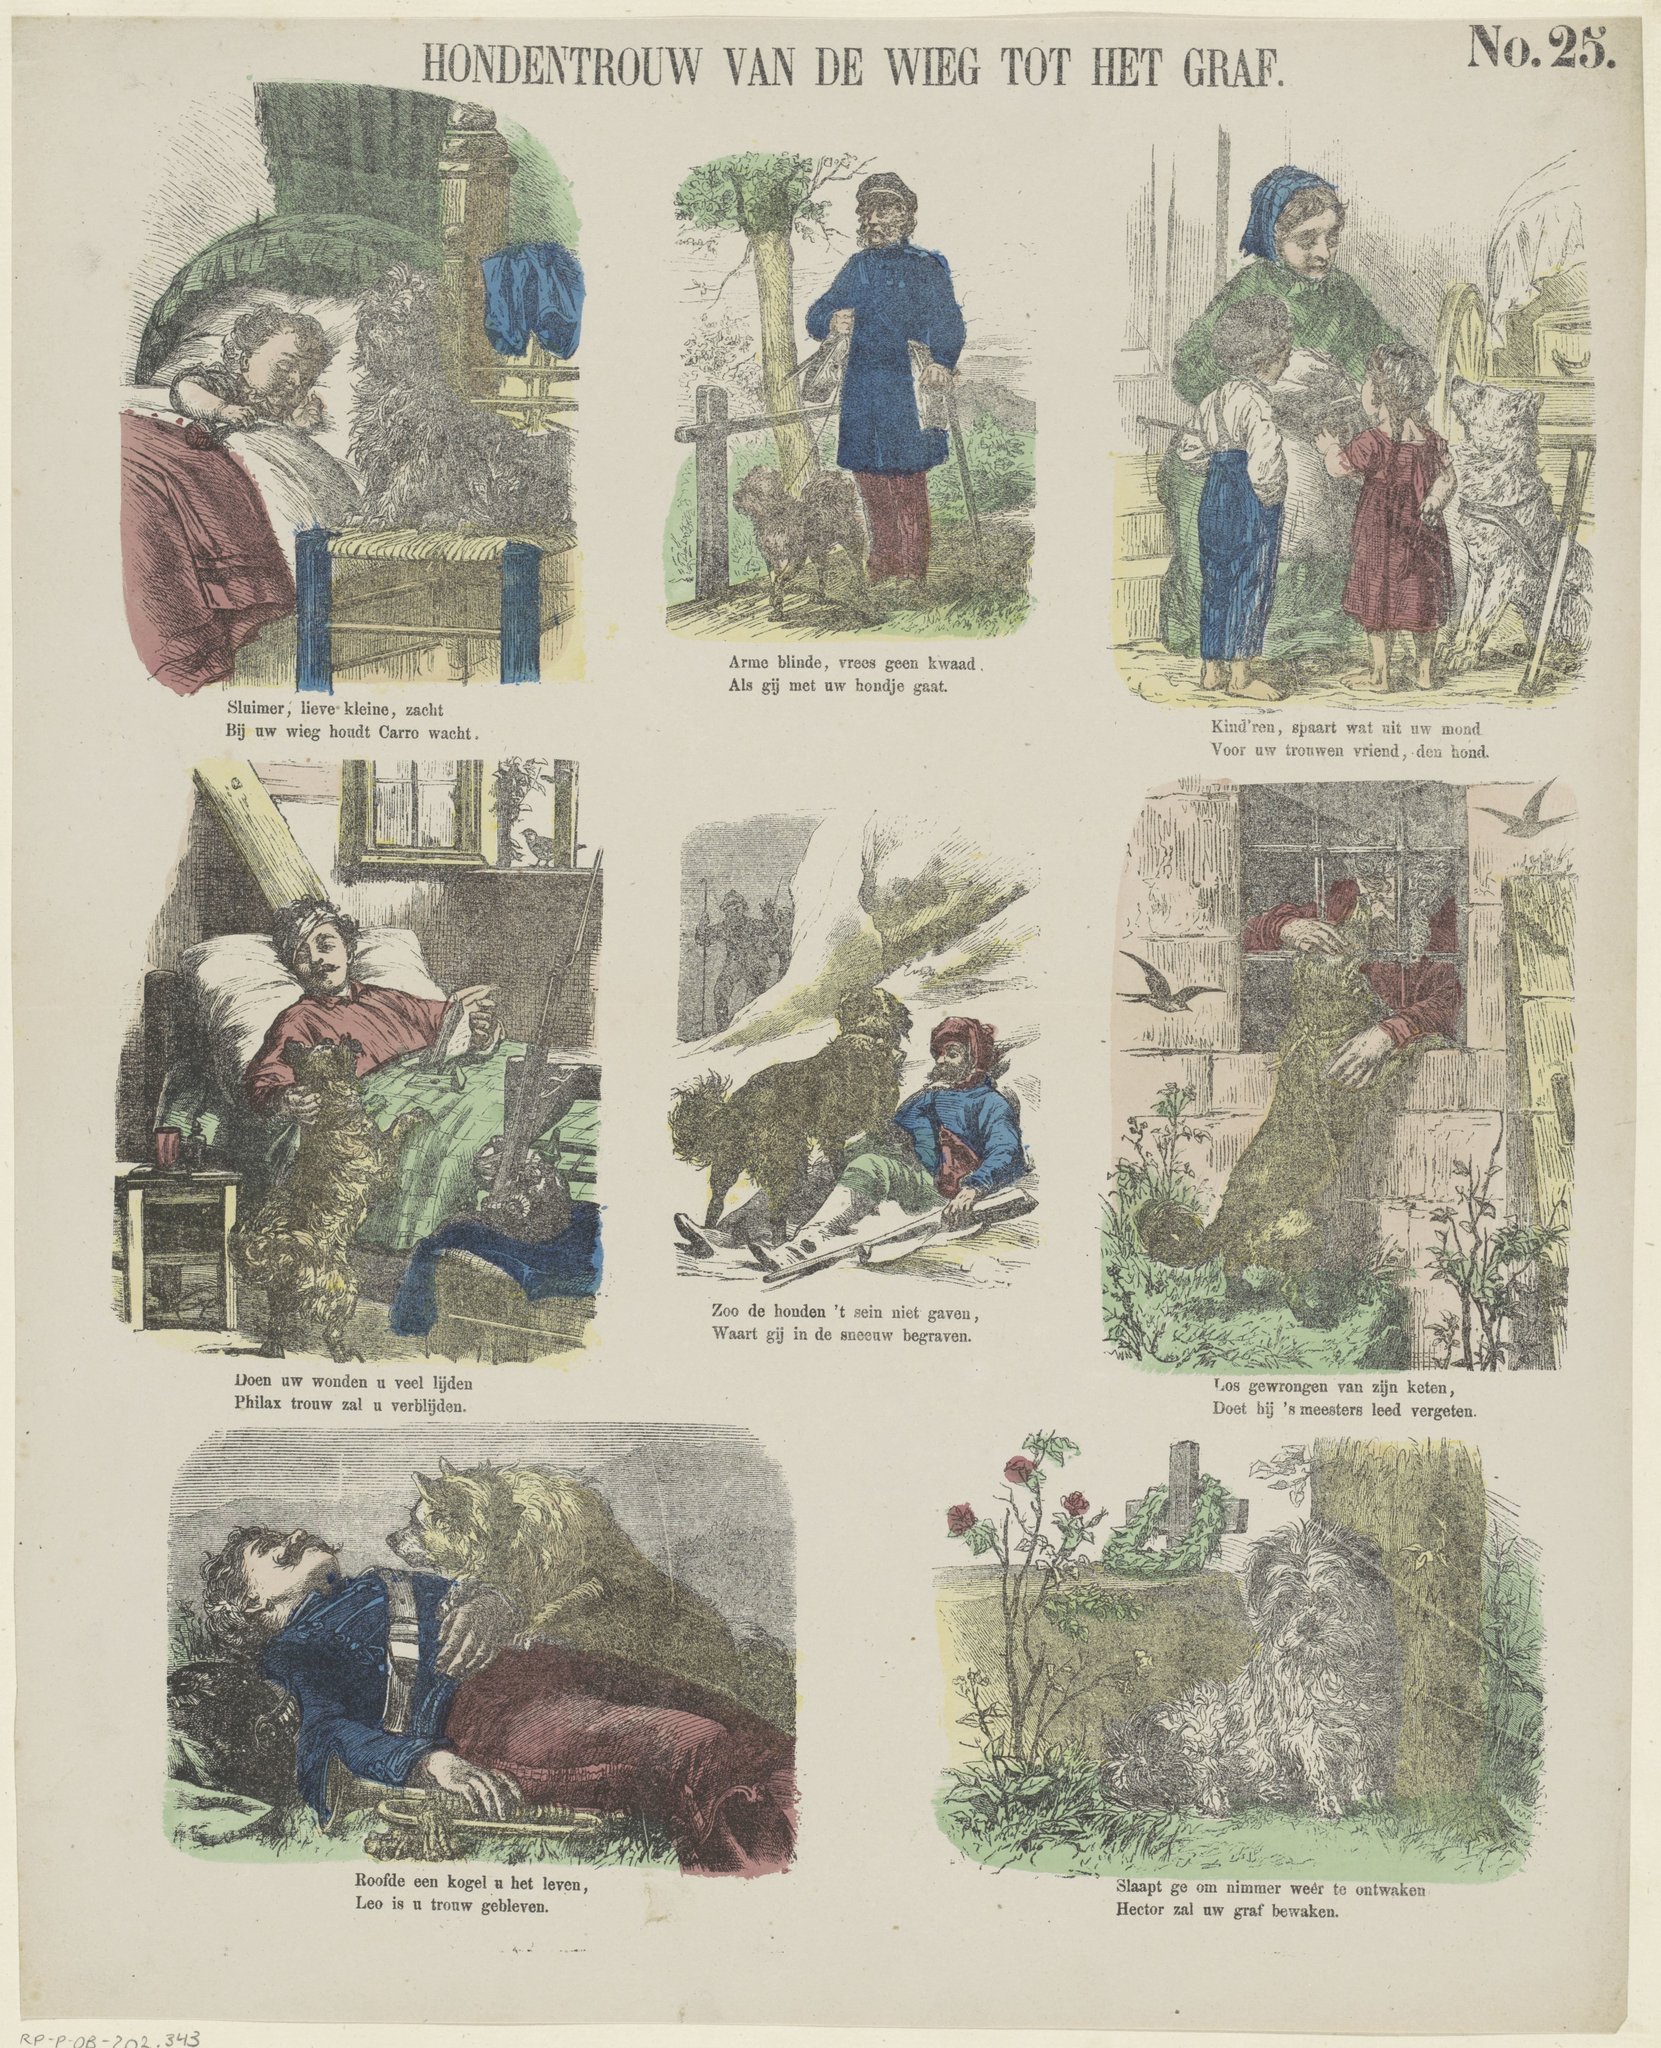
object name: popular print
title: Hondentrouw van de wieg tot het graf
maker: Anonymous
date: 1874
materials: paper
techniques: colour, letterpress printing, lithograph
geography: amsterdam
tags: dog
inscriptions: collector's mark: Lugt 2760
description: Blad met 8 voorstellingen over hoe een hond zijn baasje het hele leven trouw blijft. Onder elke afbeelding een tweeregelig vers. Genummerd rechtsboven: No. 25.